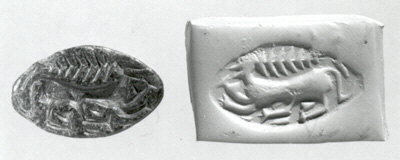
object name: stamp seal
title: Carinated half-almond seal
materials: mineral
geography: northern syria or northern mesopotamia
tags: animals